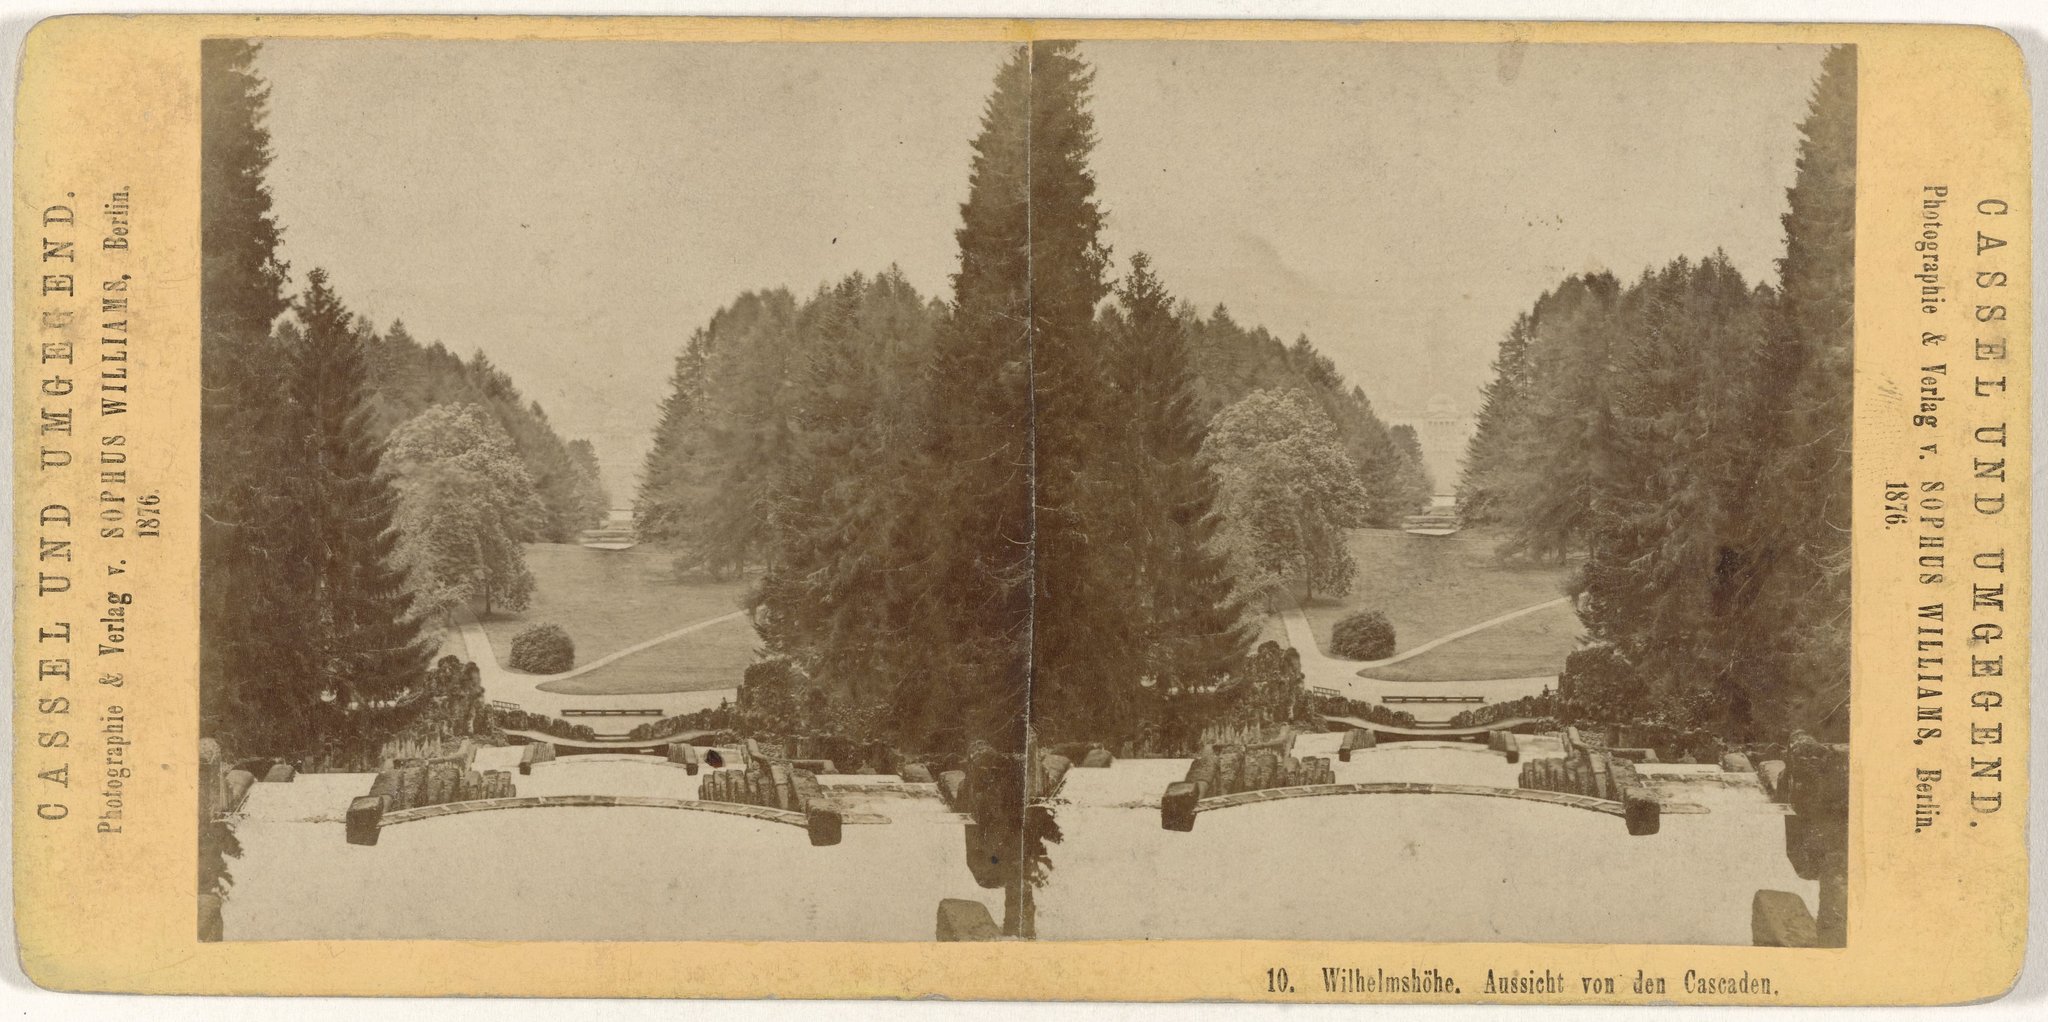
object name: stereograph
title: Wilhelmshöhe. Aussicht von den Cascaden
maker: sophus williams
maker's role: publisher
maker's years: 1835-1900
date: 1876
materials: cardboard, paper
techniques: albumen print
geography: berlin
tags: public gardens, park, garden cascade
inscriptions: number: ‘10.’